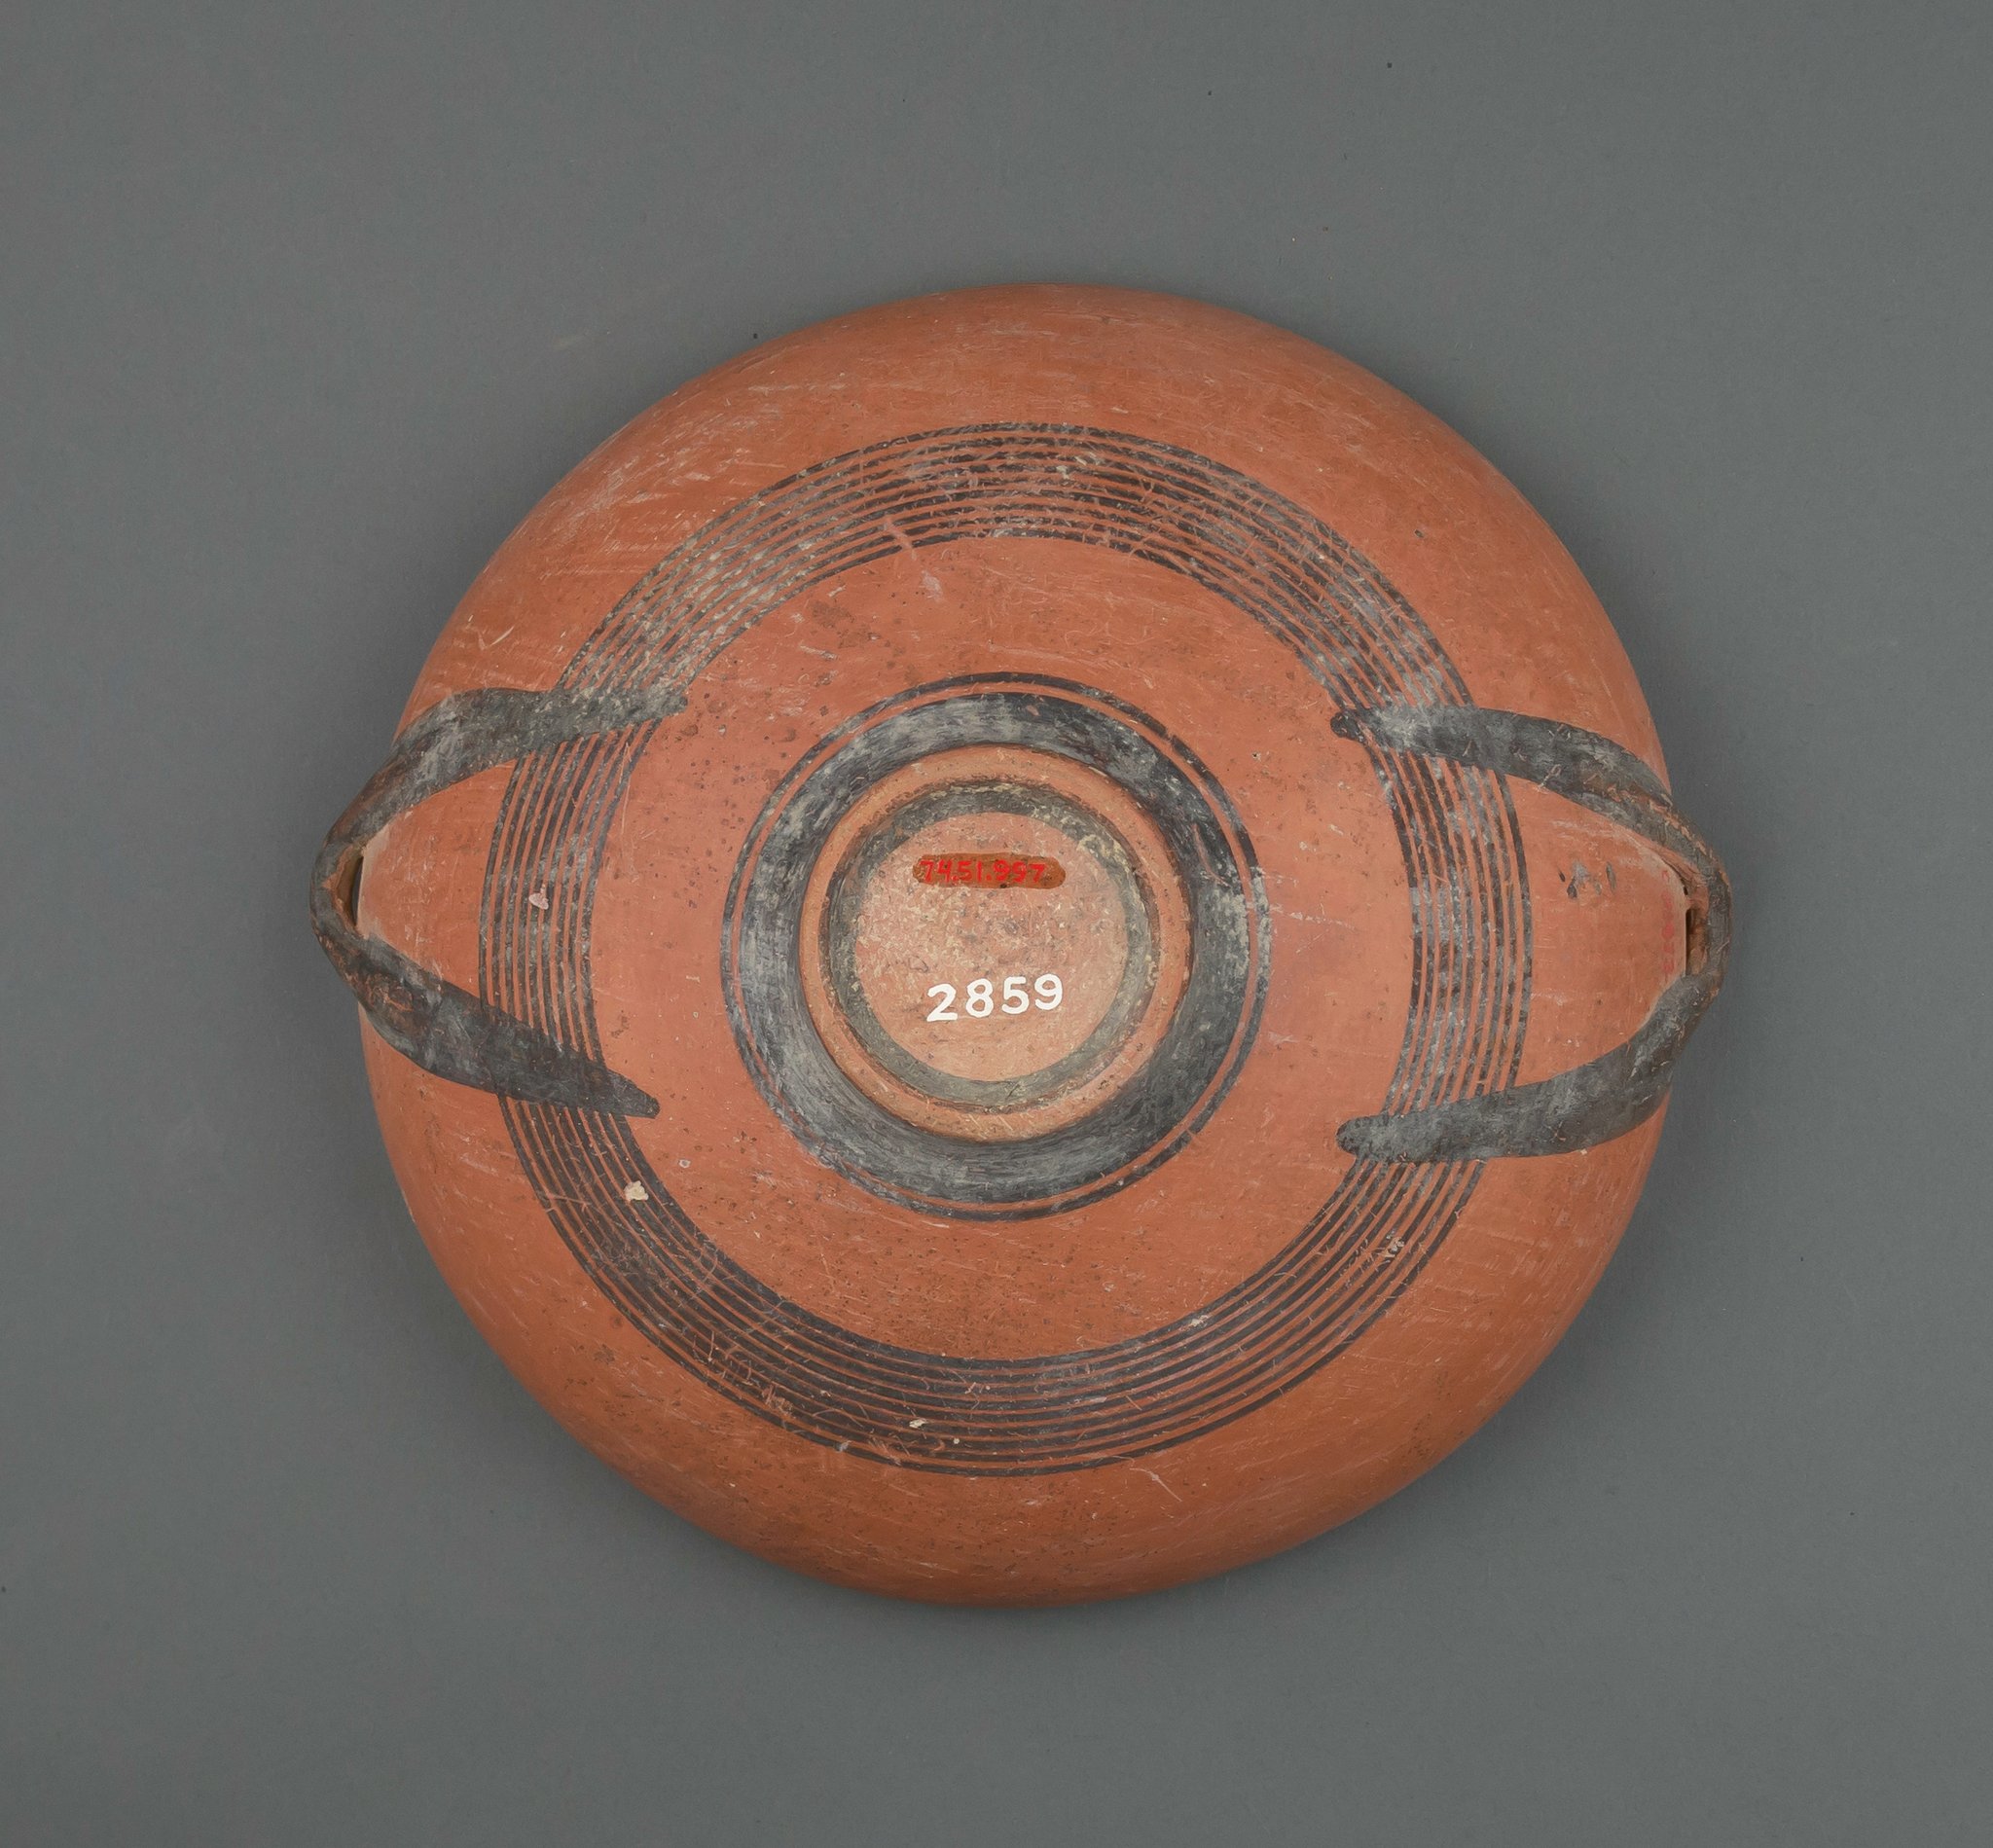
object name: bowl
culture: cypriot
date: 1050-900 BCE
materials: terracotta